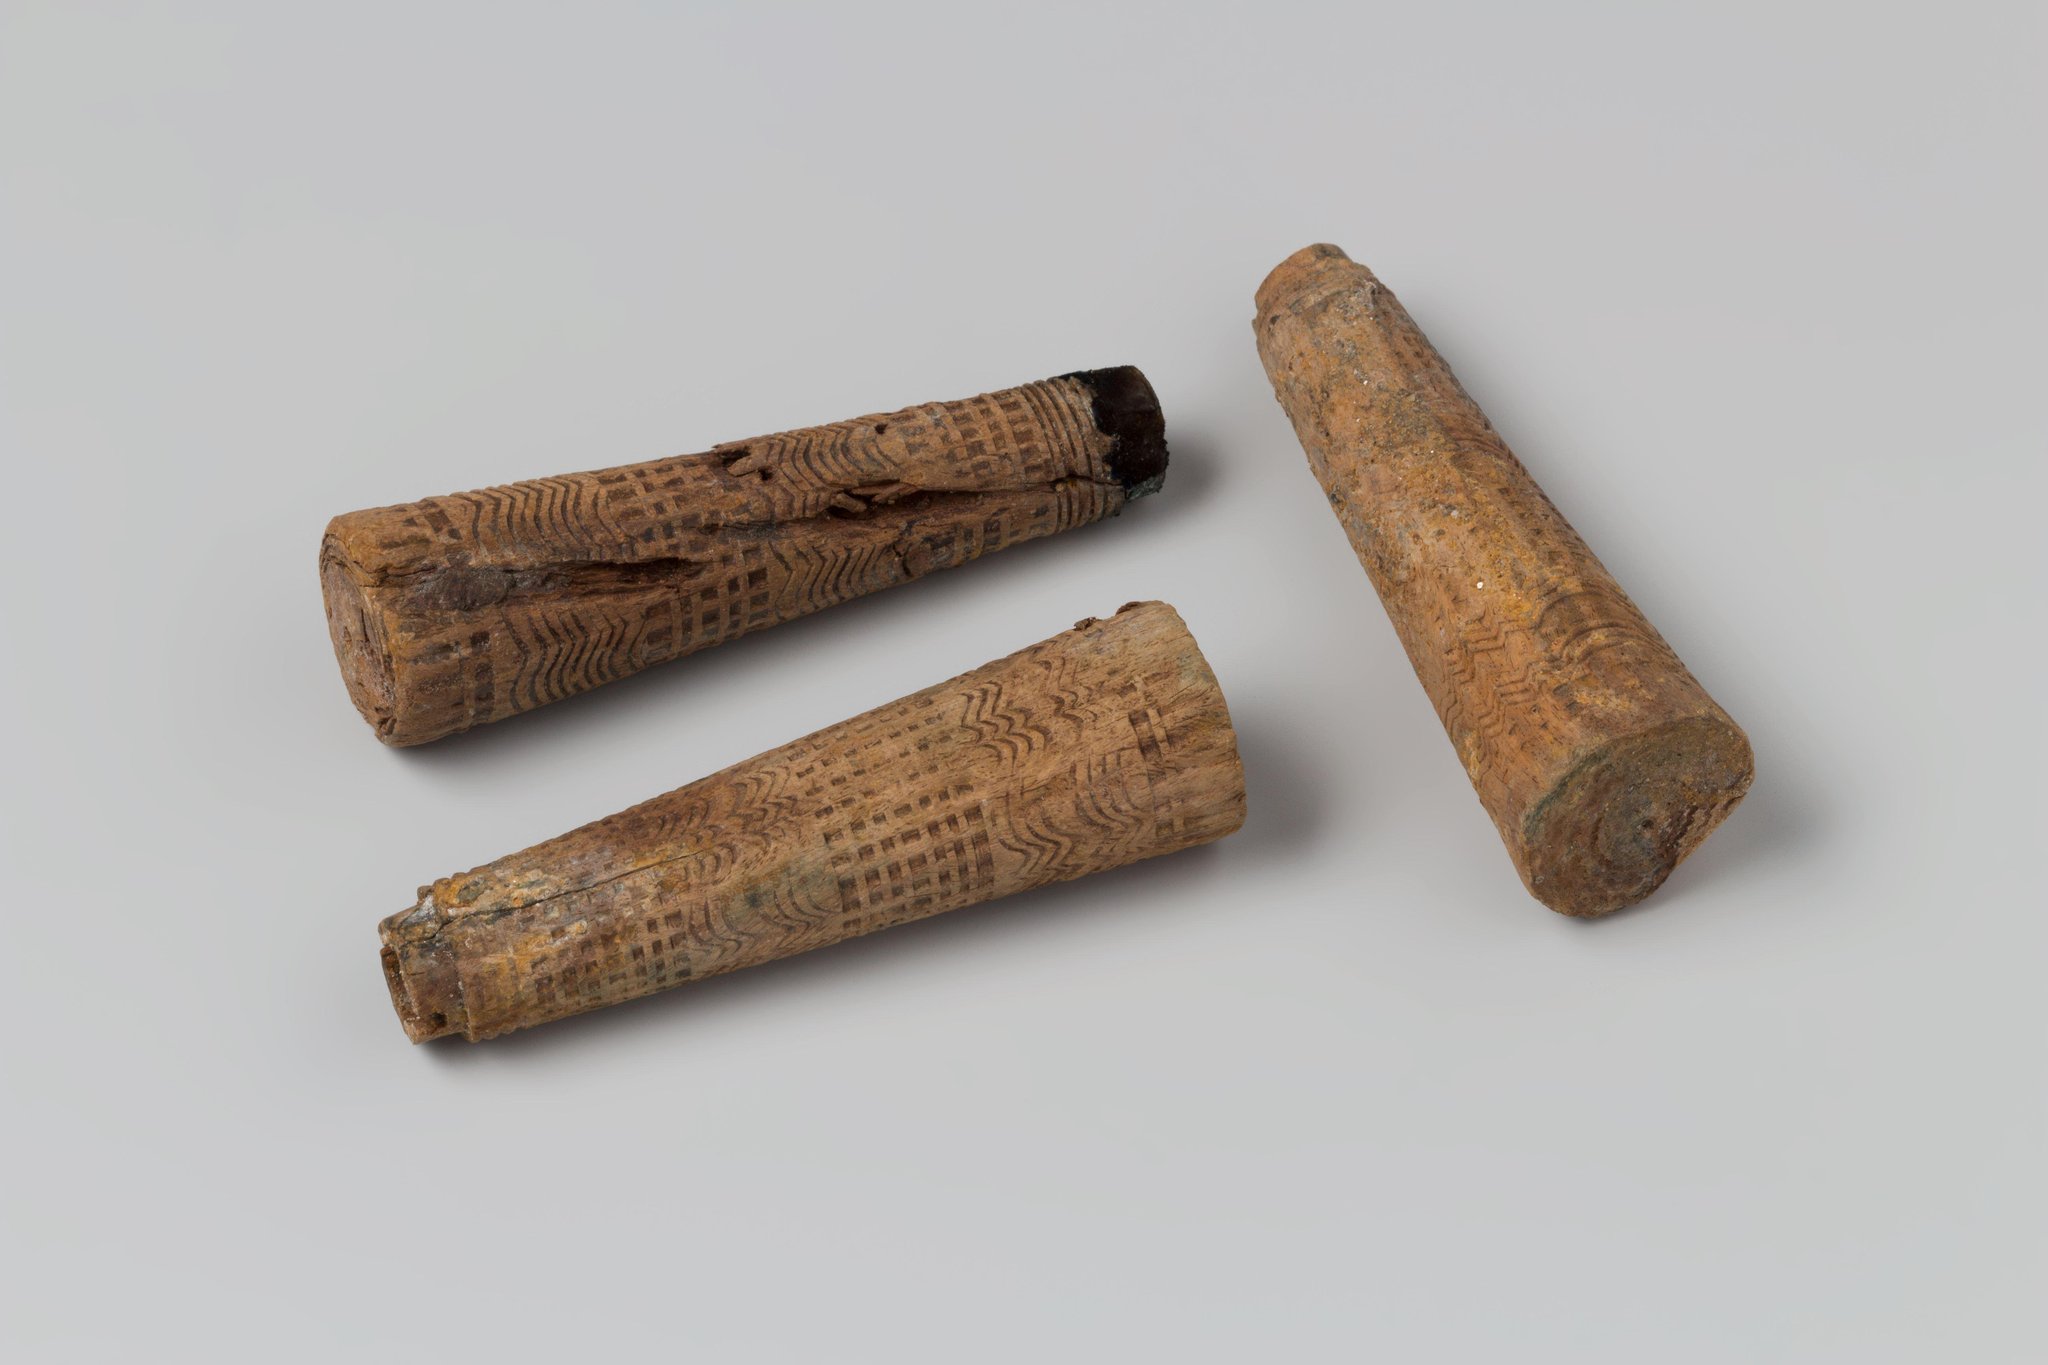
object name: knife handle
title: Messenheften uit het wrak van de Oost-Indiëvaarder Hollandia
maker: Anonymous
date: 1700-1743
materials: copper, wood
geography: netherlands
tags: verenigde oostindische compagnie, hollandia (schip), annet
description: Knife, handle, cylindrical: tapering; id. NG 1979-403H, ferrule, id. NG 1980-27H426.